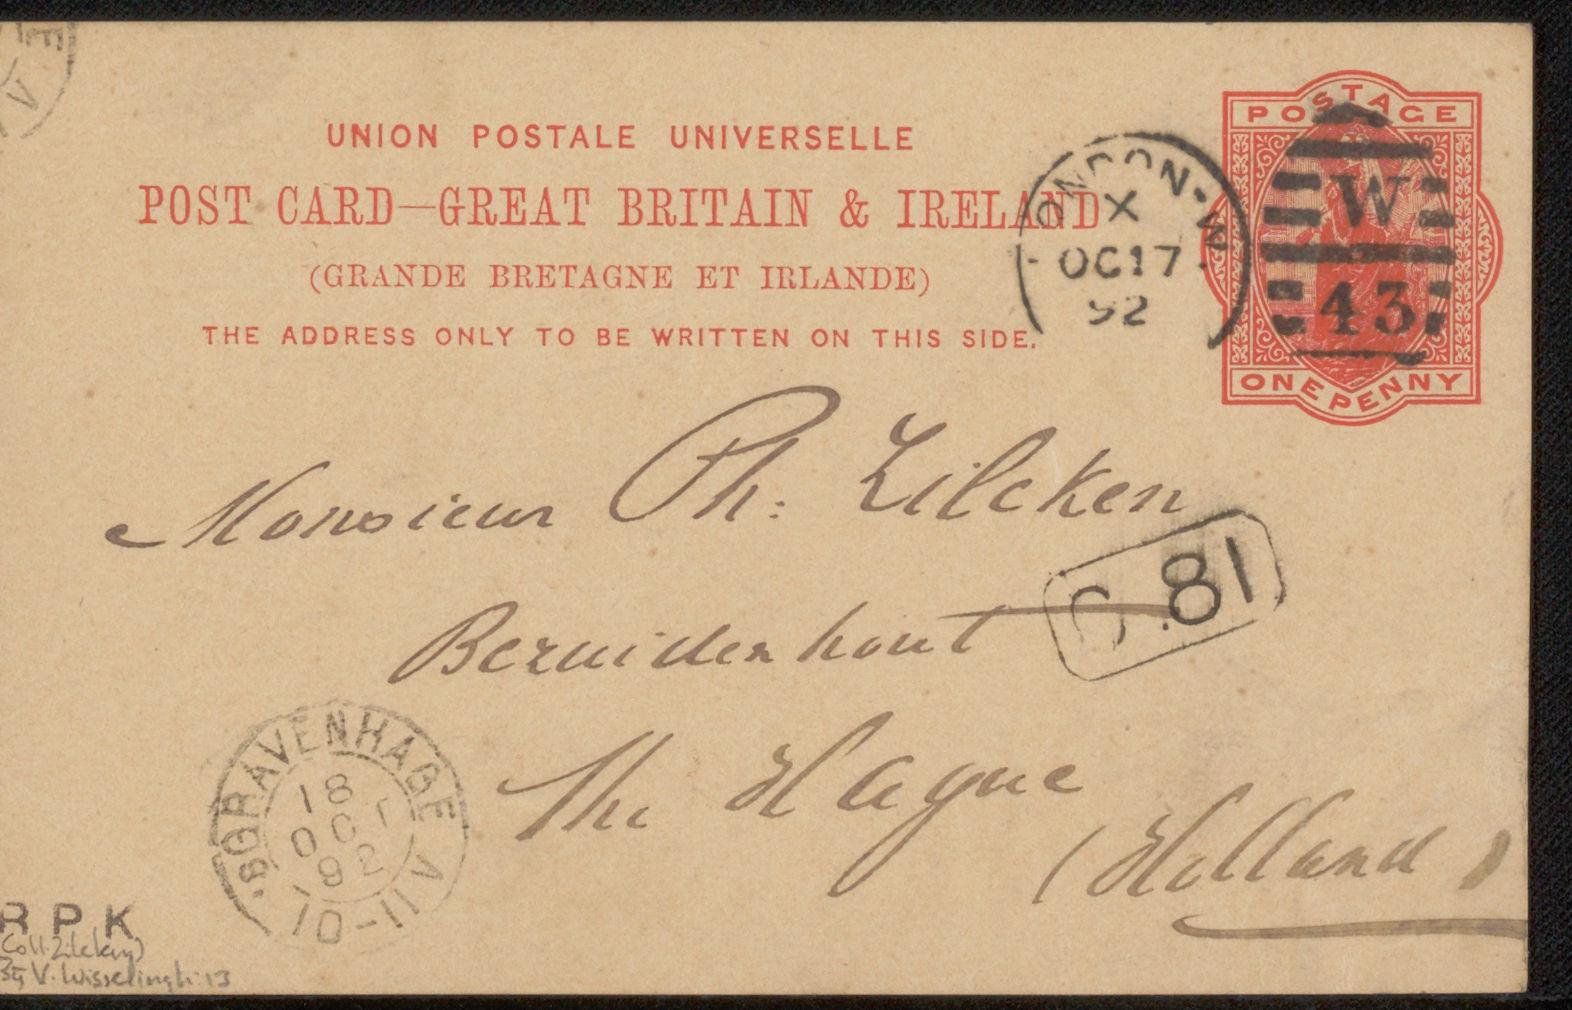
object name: postcard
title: Briefkaart aan Philip Zilcken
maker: elbert jan van wisselingh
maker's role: kunsthandelaar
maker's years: 1848-1912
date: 1892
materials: cardboard, ink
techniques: pen, writing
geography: london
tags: james abbott mcneill whistler, paris, print maker, félix hilaire buhot, the hague, painter, philip zilcken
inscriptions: collector's mark: ‘RPK’